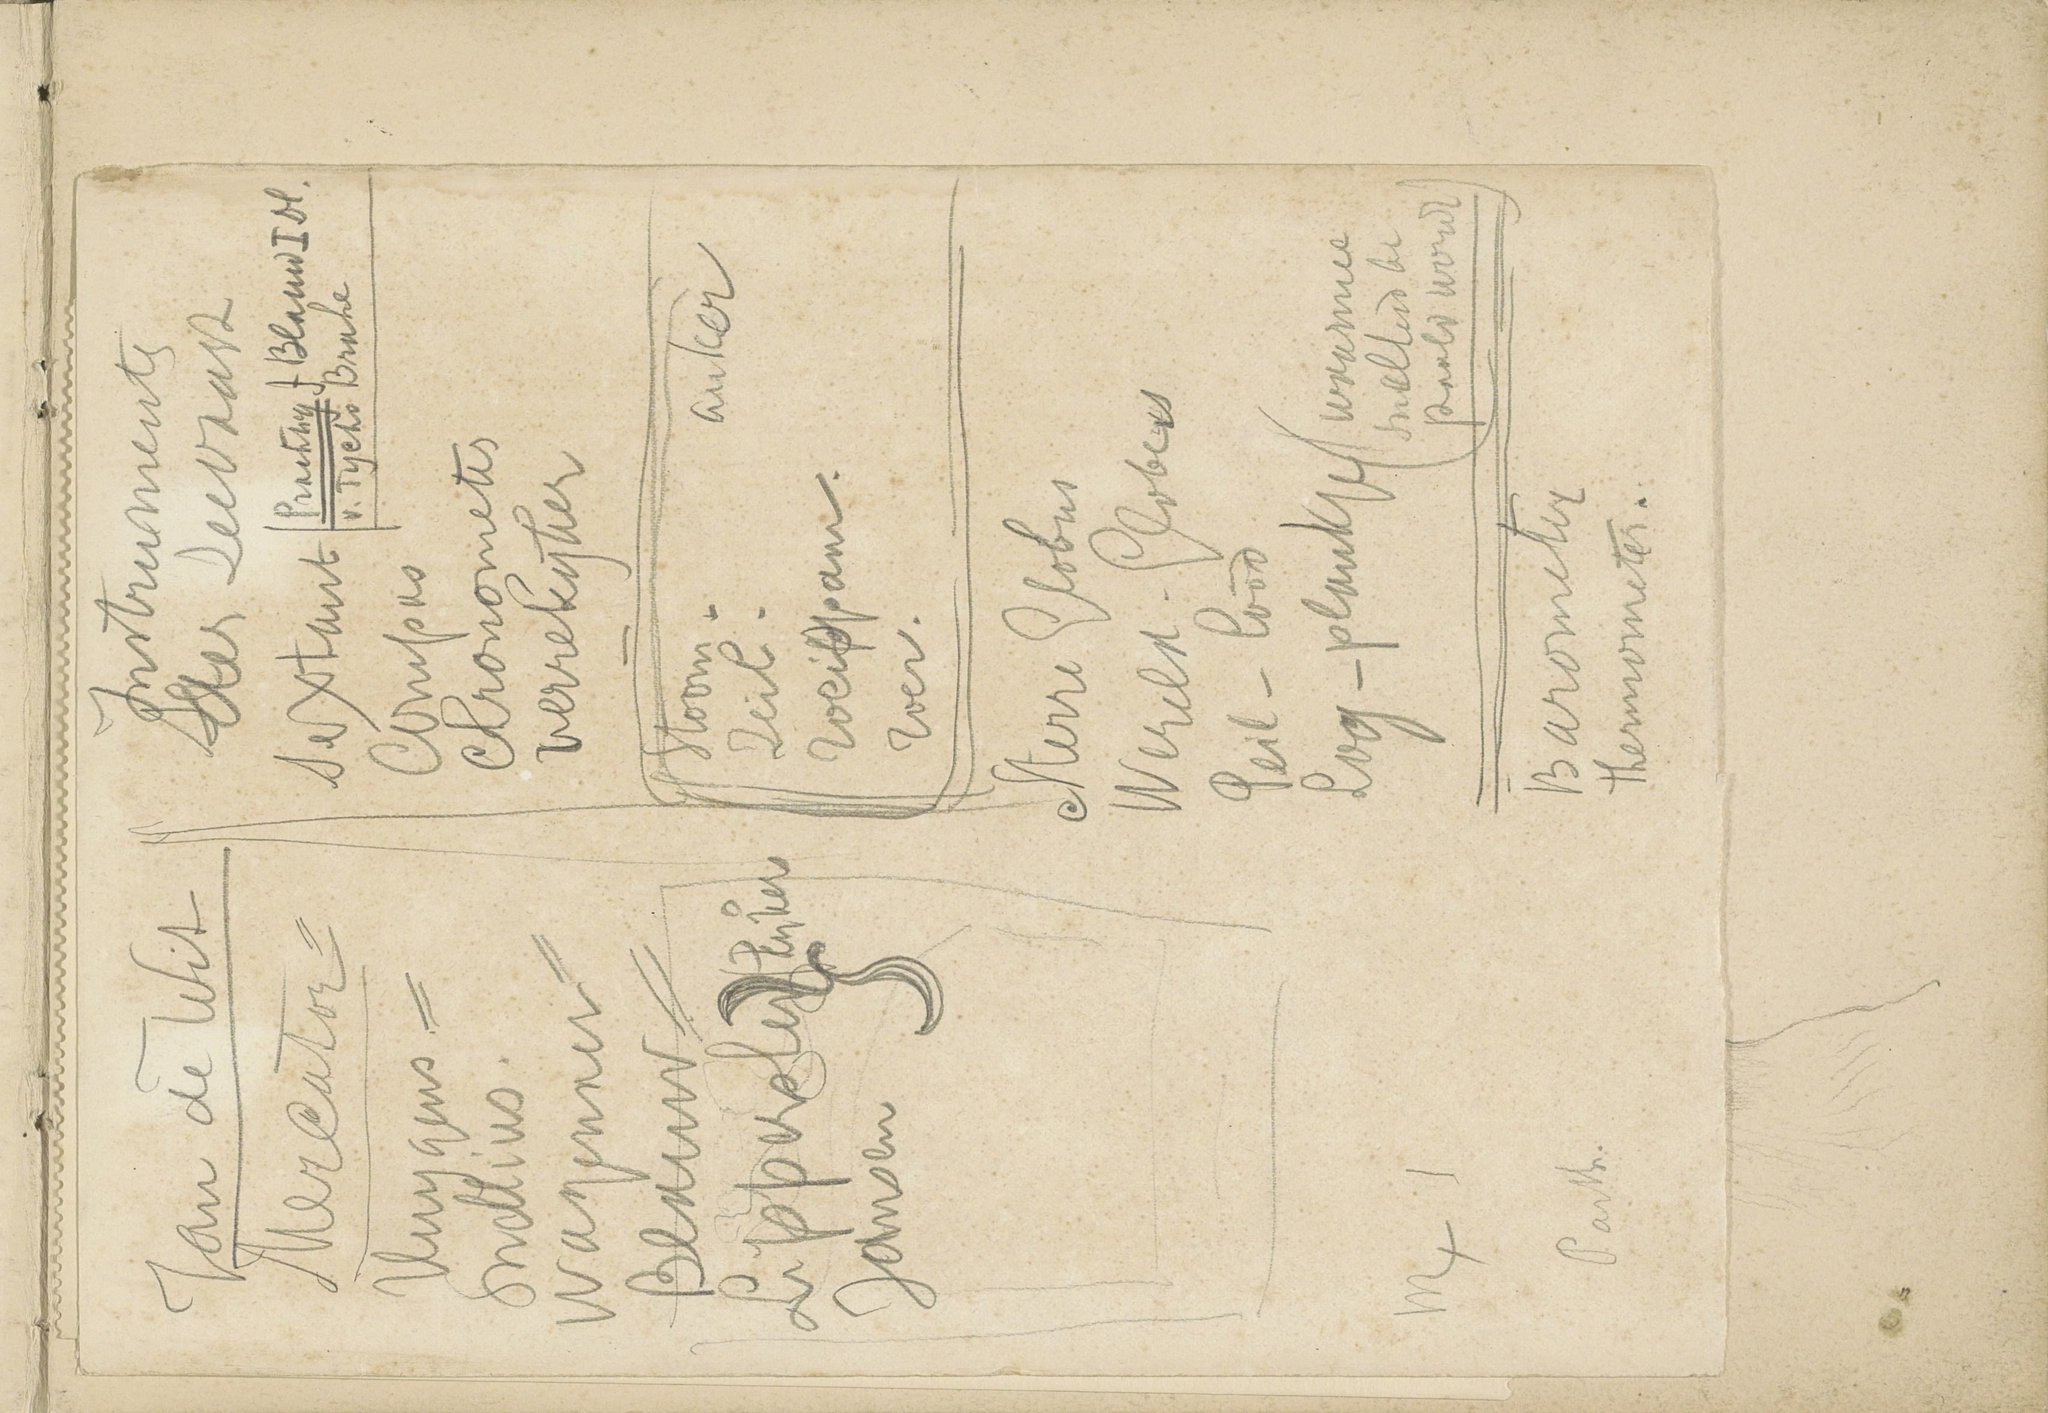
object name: sketchbook leaf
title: Studie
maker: antoon derkinderen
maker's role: draughtsman, painter, print maker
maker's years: 1859-1925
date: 1869-1925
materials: paper, pencil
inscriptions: annotation: ‘Jan de Wit/ Mercator/ Huygens/ [...]’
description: Recto van een losse tekening tussen het voorste schutblad en blad 1 uit een schetsboek met 28 bladen.